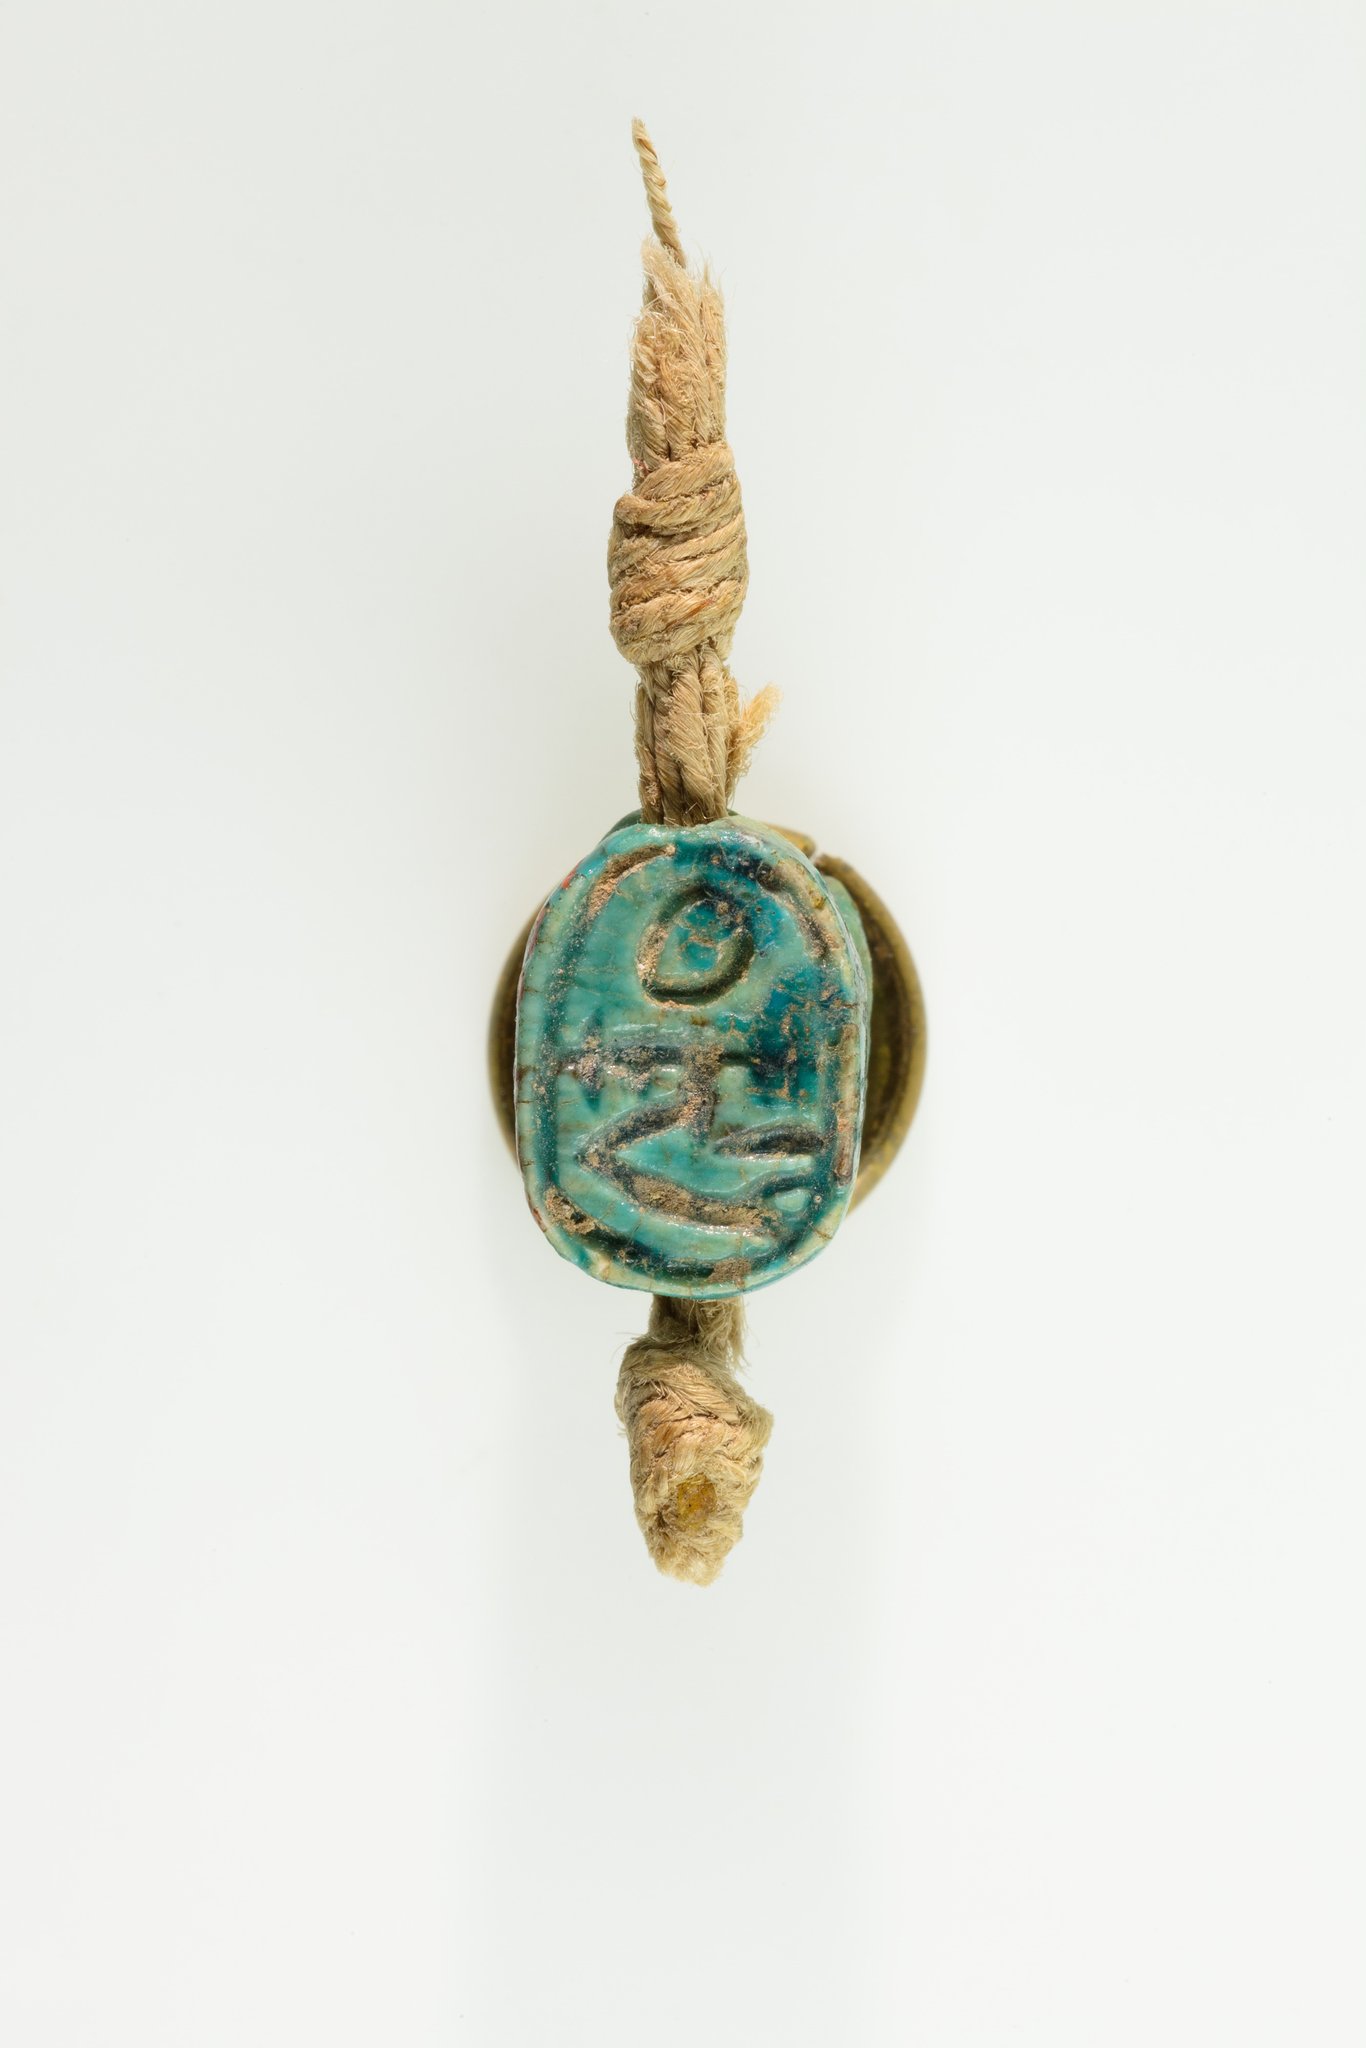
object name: scarab, amenemhat iii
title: Seal in the shape of a hedgehog on original string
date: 1859-1813 BCE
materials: stone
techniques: glazing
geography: egypt